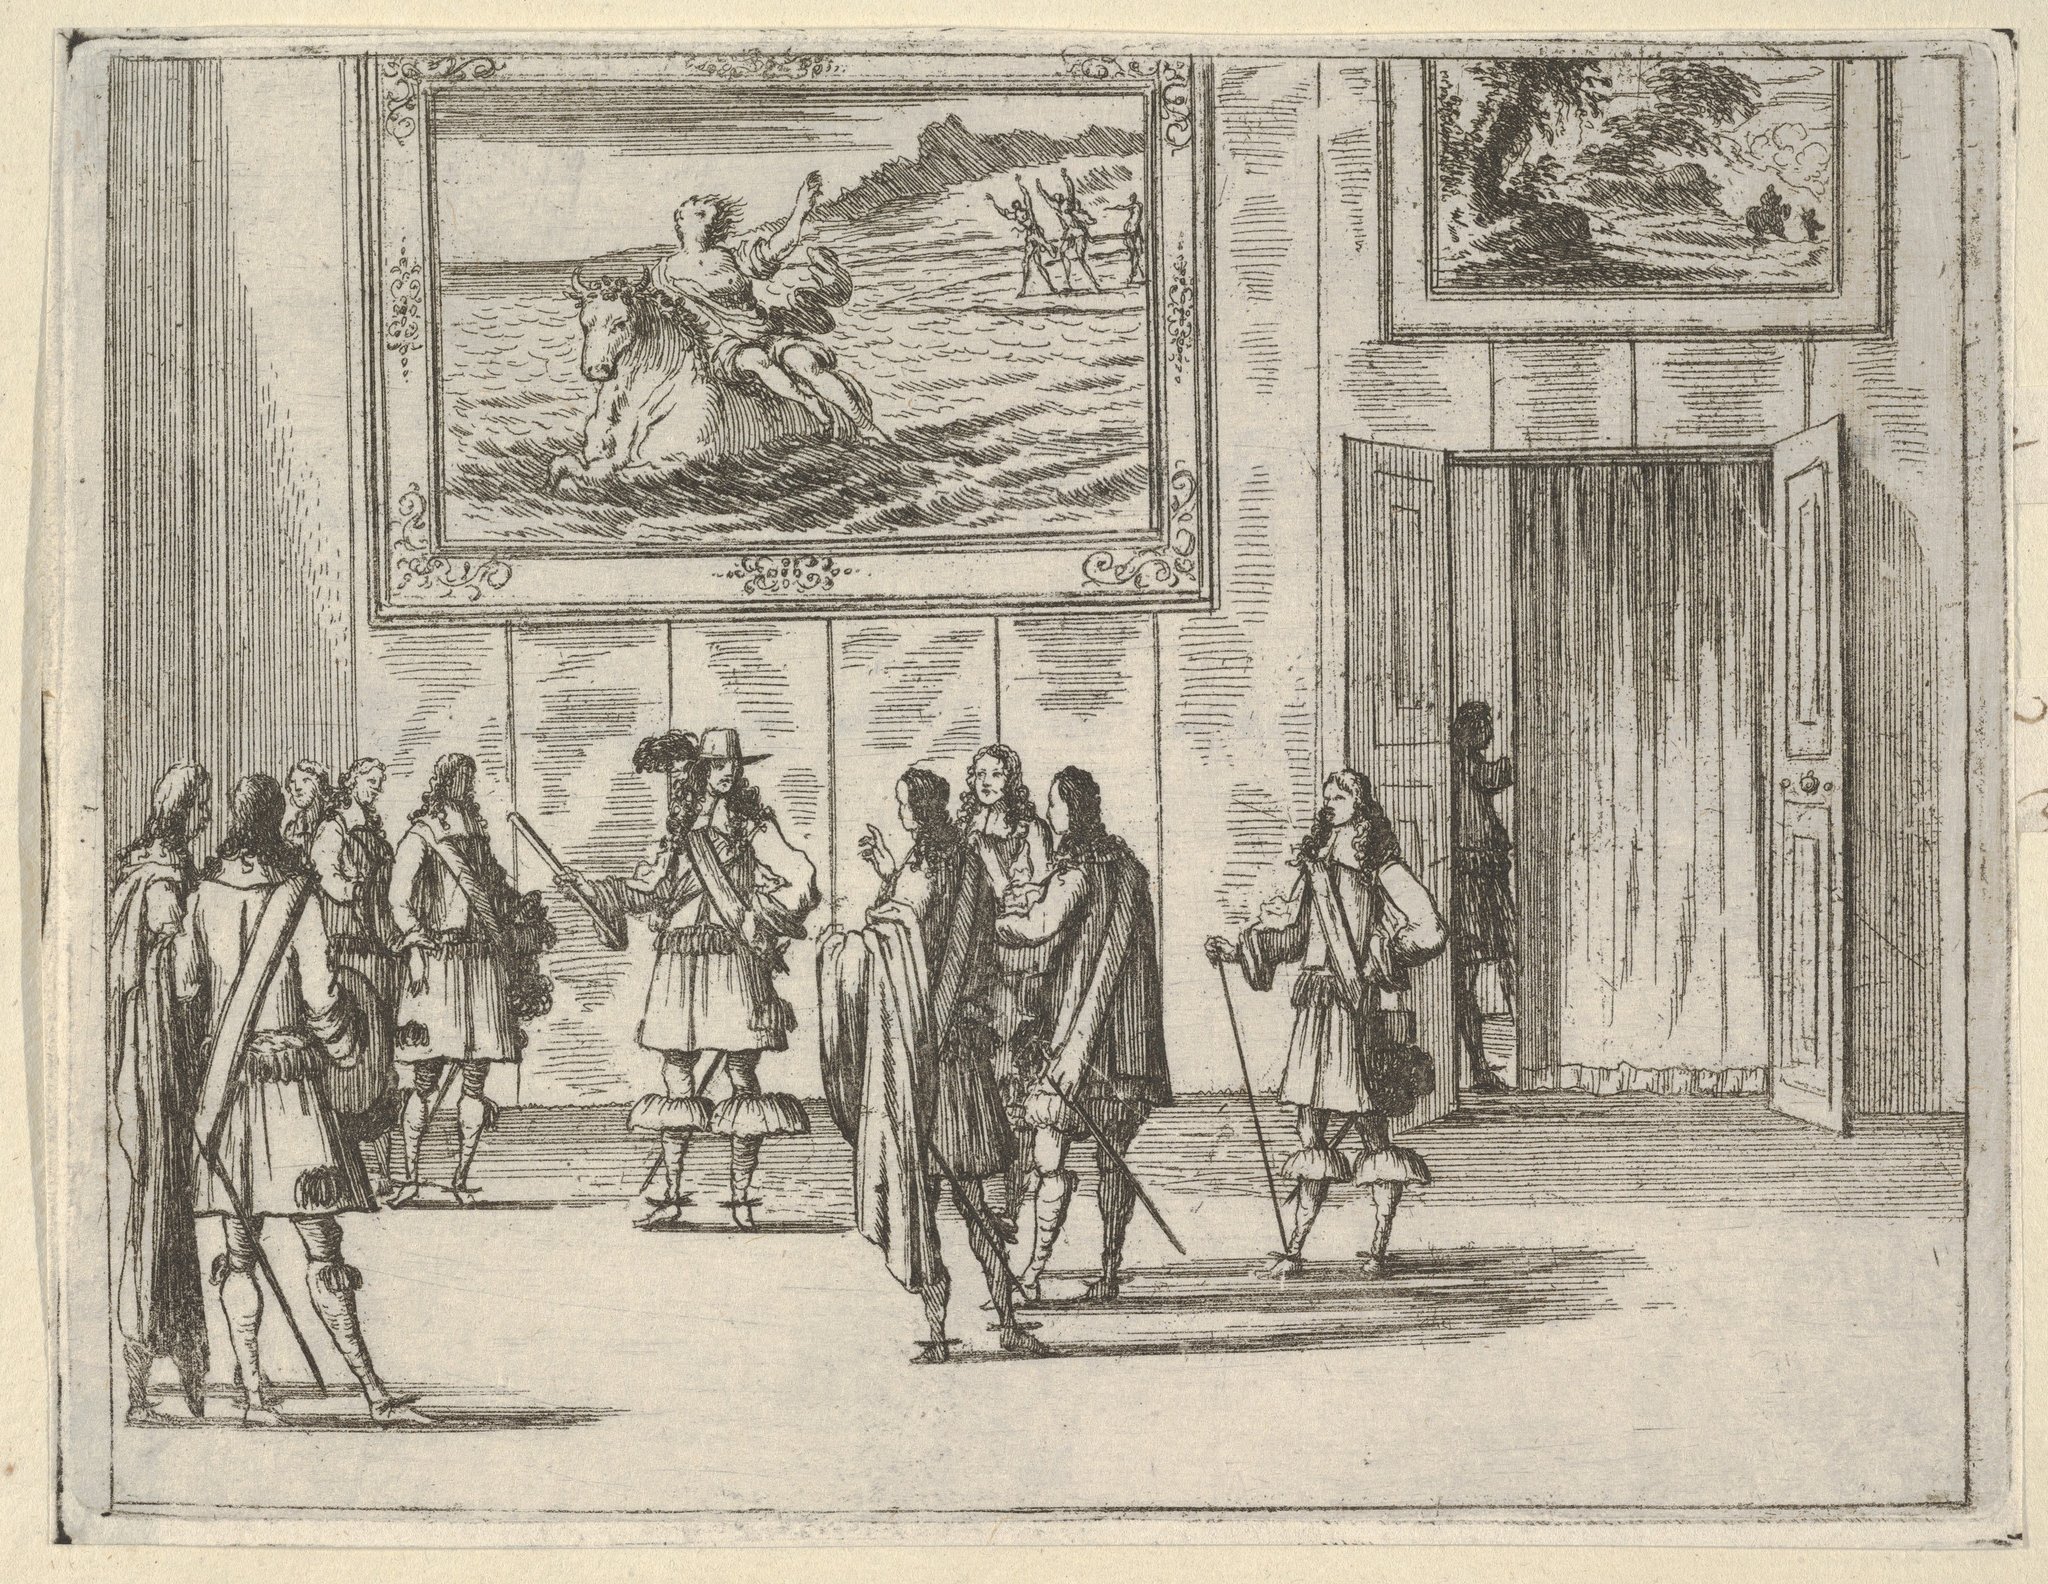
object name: print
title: Francesco I d'Este Receives the General of the French King's Army in Italy, depicted in a room beneath The Rape of Europa, from "L'Idea di un Principe ed Eroe Cristiano in Francesco I d'Este, di Modena e Reggio Duca VIII [...]"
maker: bartolomeo fenice (fénis)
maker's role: artist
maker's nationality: italian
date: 1659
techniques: etching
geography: italy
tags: army,men,europa,generals